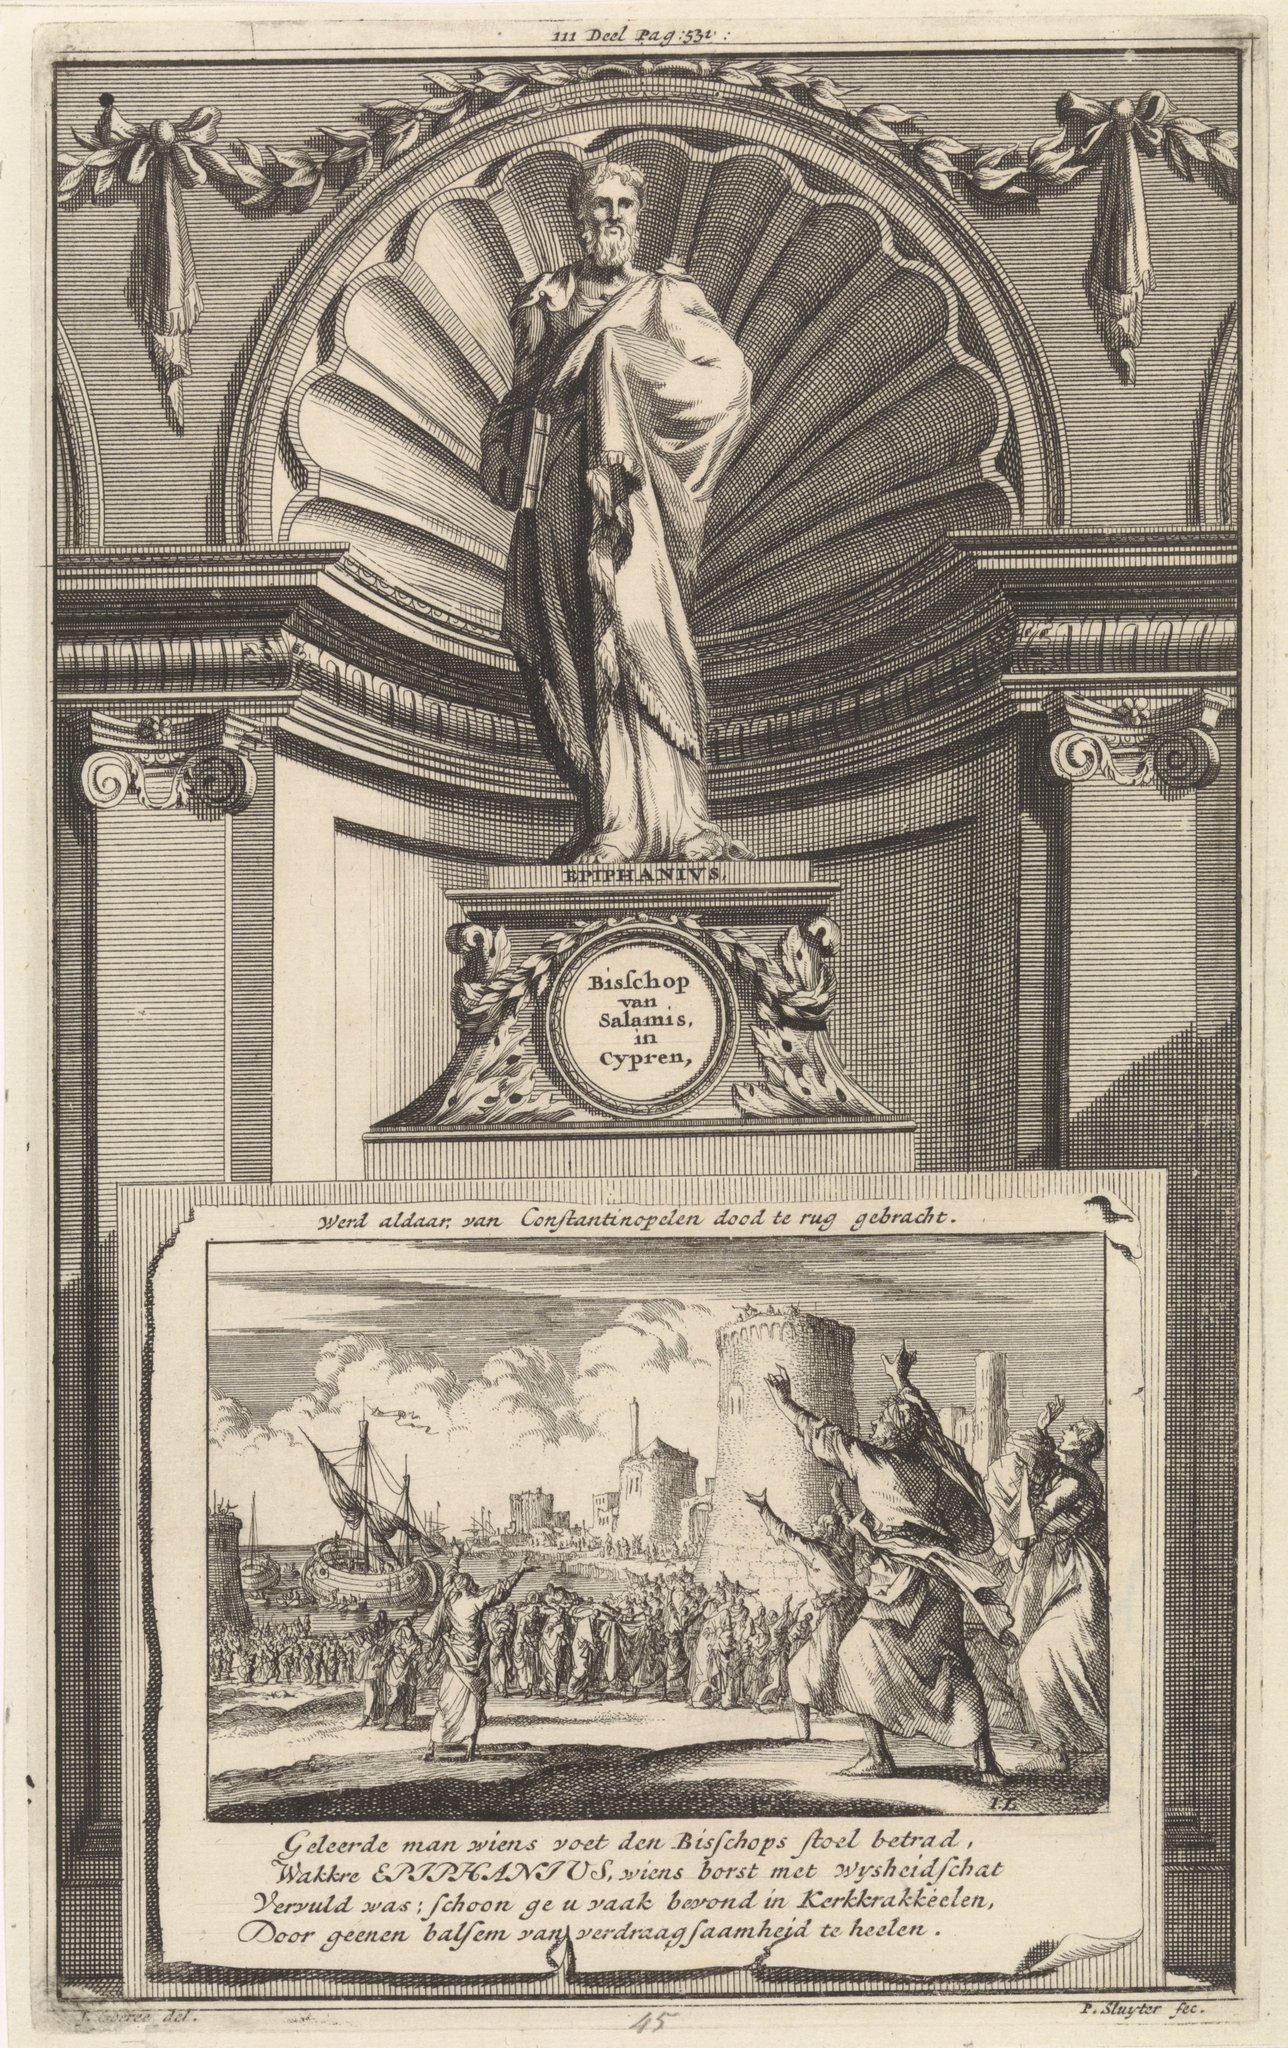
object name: book illustration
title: Epiphanius, Bisschop van Salamis, in Cypren, Werd aldaar, van Constantinopelen dood te rug gebracht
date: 1698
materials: paper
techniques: engraving, etching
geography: amsterdam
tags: male saints (epiphanius of salamis) - martyrdom, suffering, misfortune, death of male saint, male saints (epiphanius of salamis)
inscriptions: collector's mark: Lugt 2228, number: ‘45’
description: De heilige kerkvader Epiphanius van Salamis, staand op een sokkel. Op de voorzijde een scène waarin het lichaam van de overleden Epiphanius wordt teruggebracht naar Constantinopel. Prent middenboven gemerkt: III Deel Pag: 531.